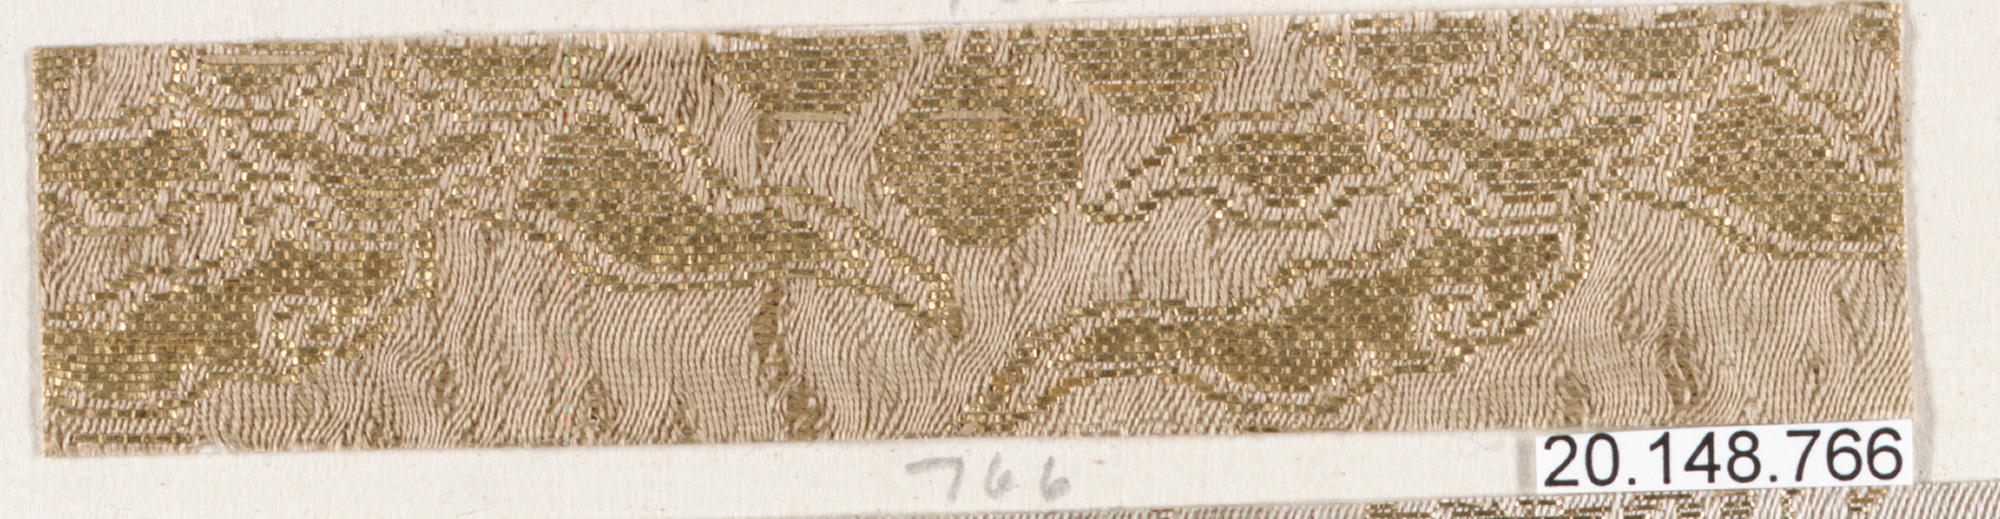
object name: piece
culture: japanese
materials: silk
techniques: compound weave